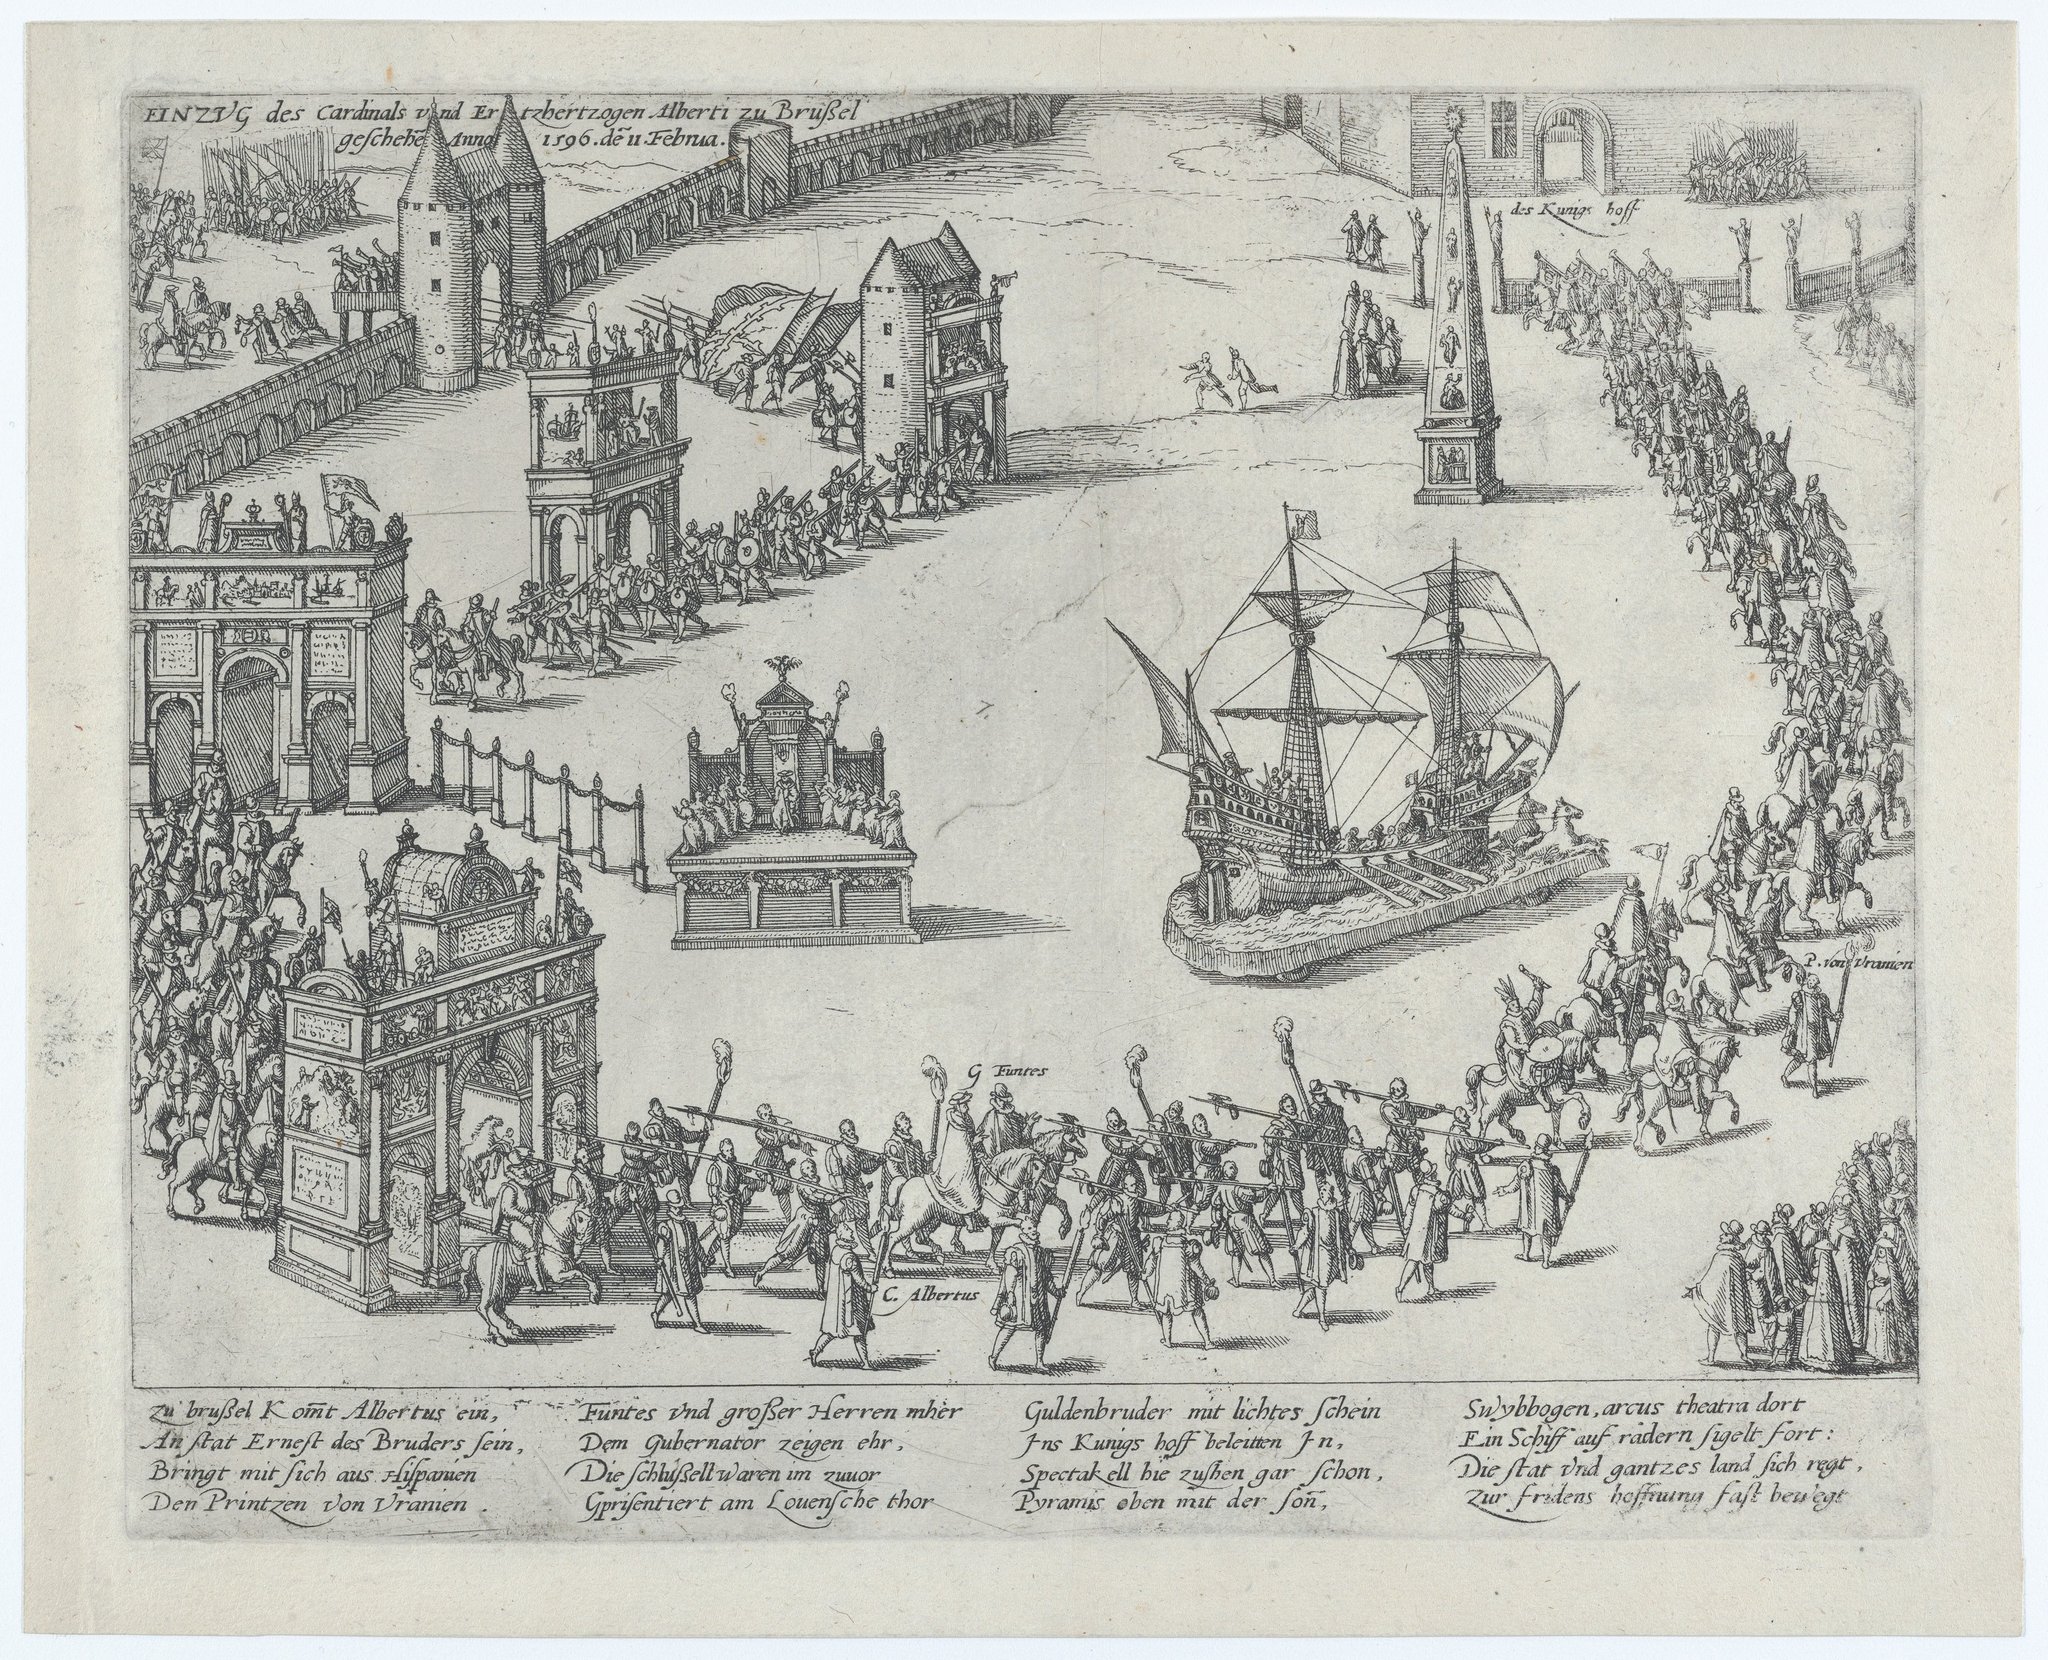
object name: print, fete, ornament architecture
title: Entrance of the Cardinal and Archduke Albert to Brussels in 1596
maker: anonymous, 16th century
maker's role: artist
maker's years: 1500-1600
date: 1596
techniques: etching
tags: gates,soldiers,horses,crowd